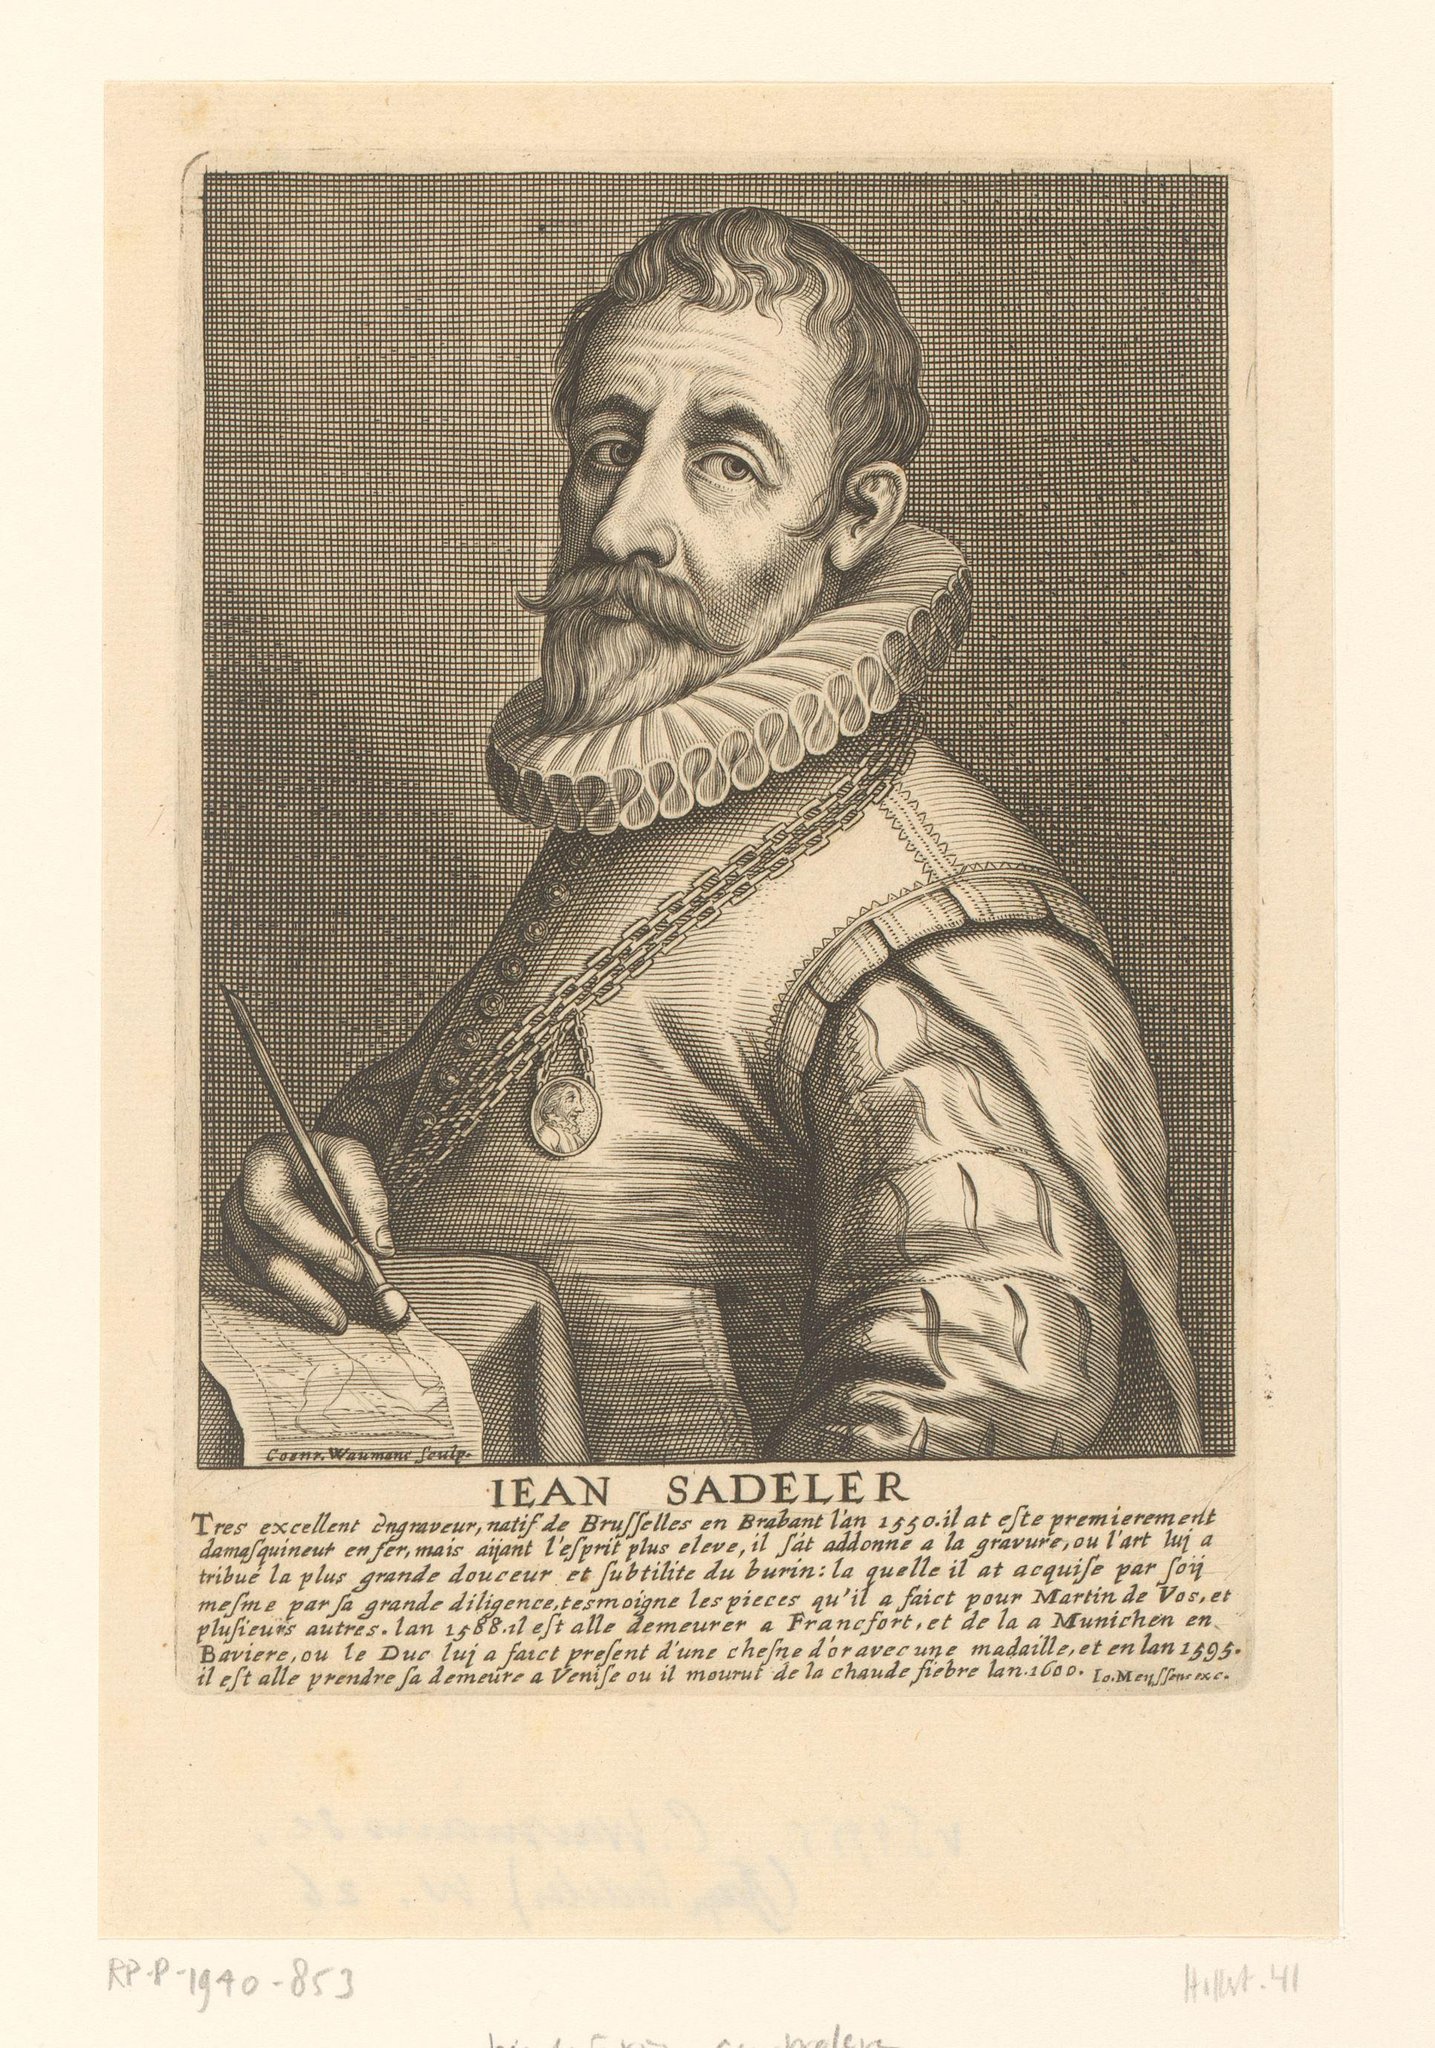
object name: print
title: Portretten van kunstenaars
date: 1649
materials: paper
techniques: engraving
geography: antwerp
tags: venice, print maker, johann sadeler (i), tools, implements of graphic artist (burin), historical persons, portrait, self-portrait of graphic artist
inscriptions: collector's mark: Lugt 2228, collector's mark: Lugt 2760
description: Prent ook gebruikt in publicaties uit 1662 en 1705.